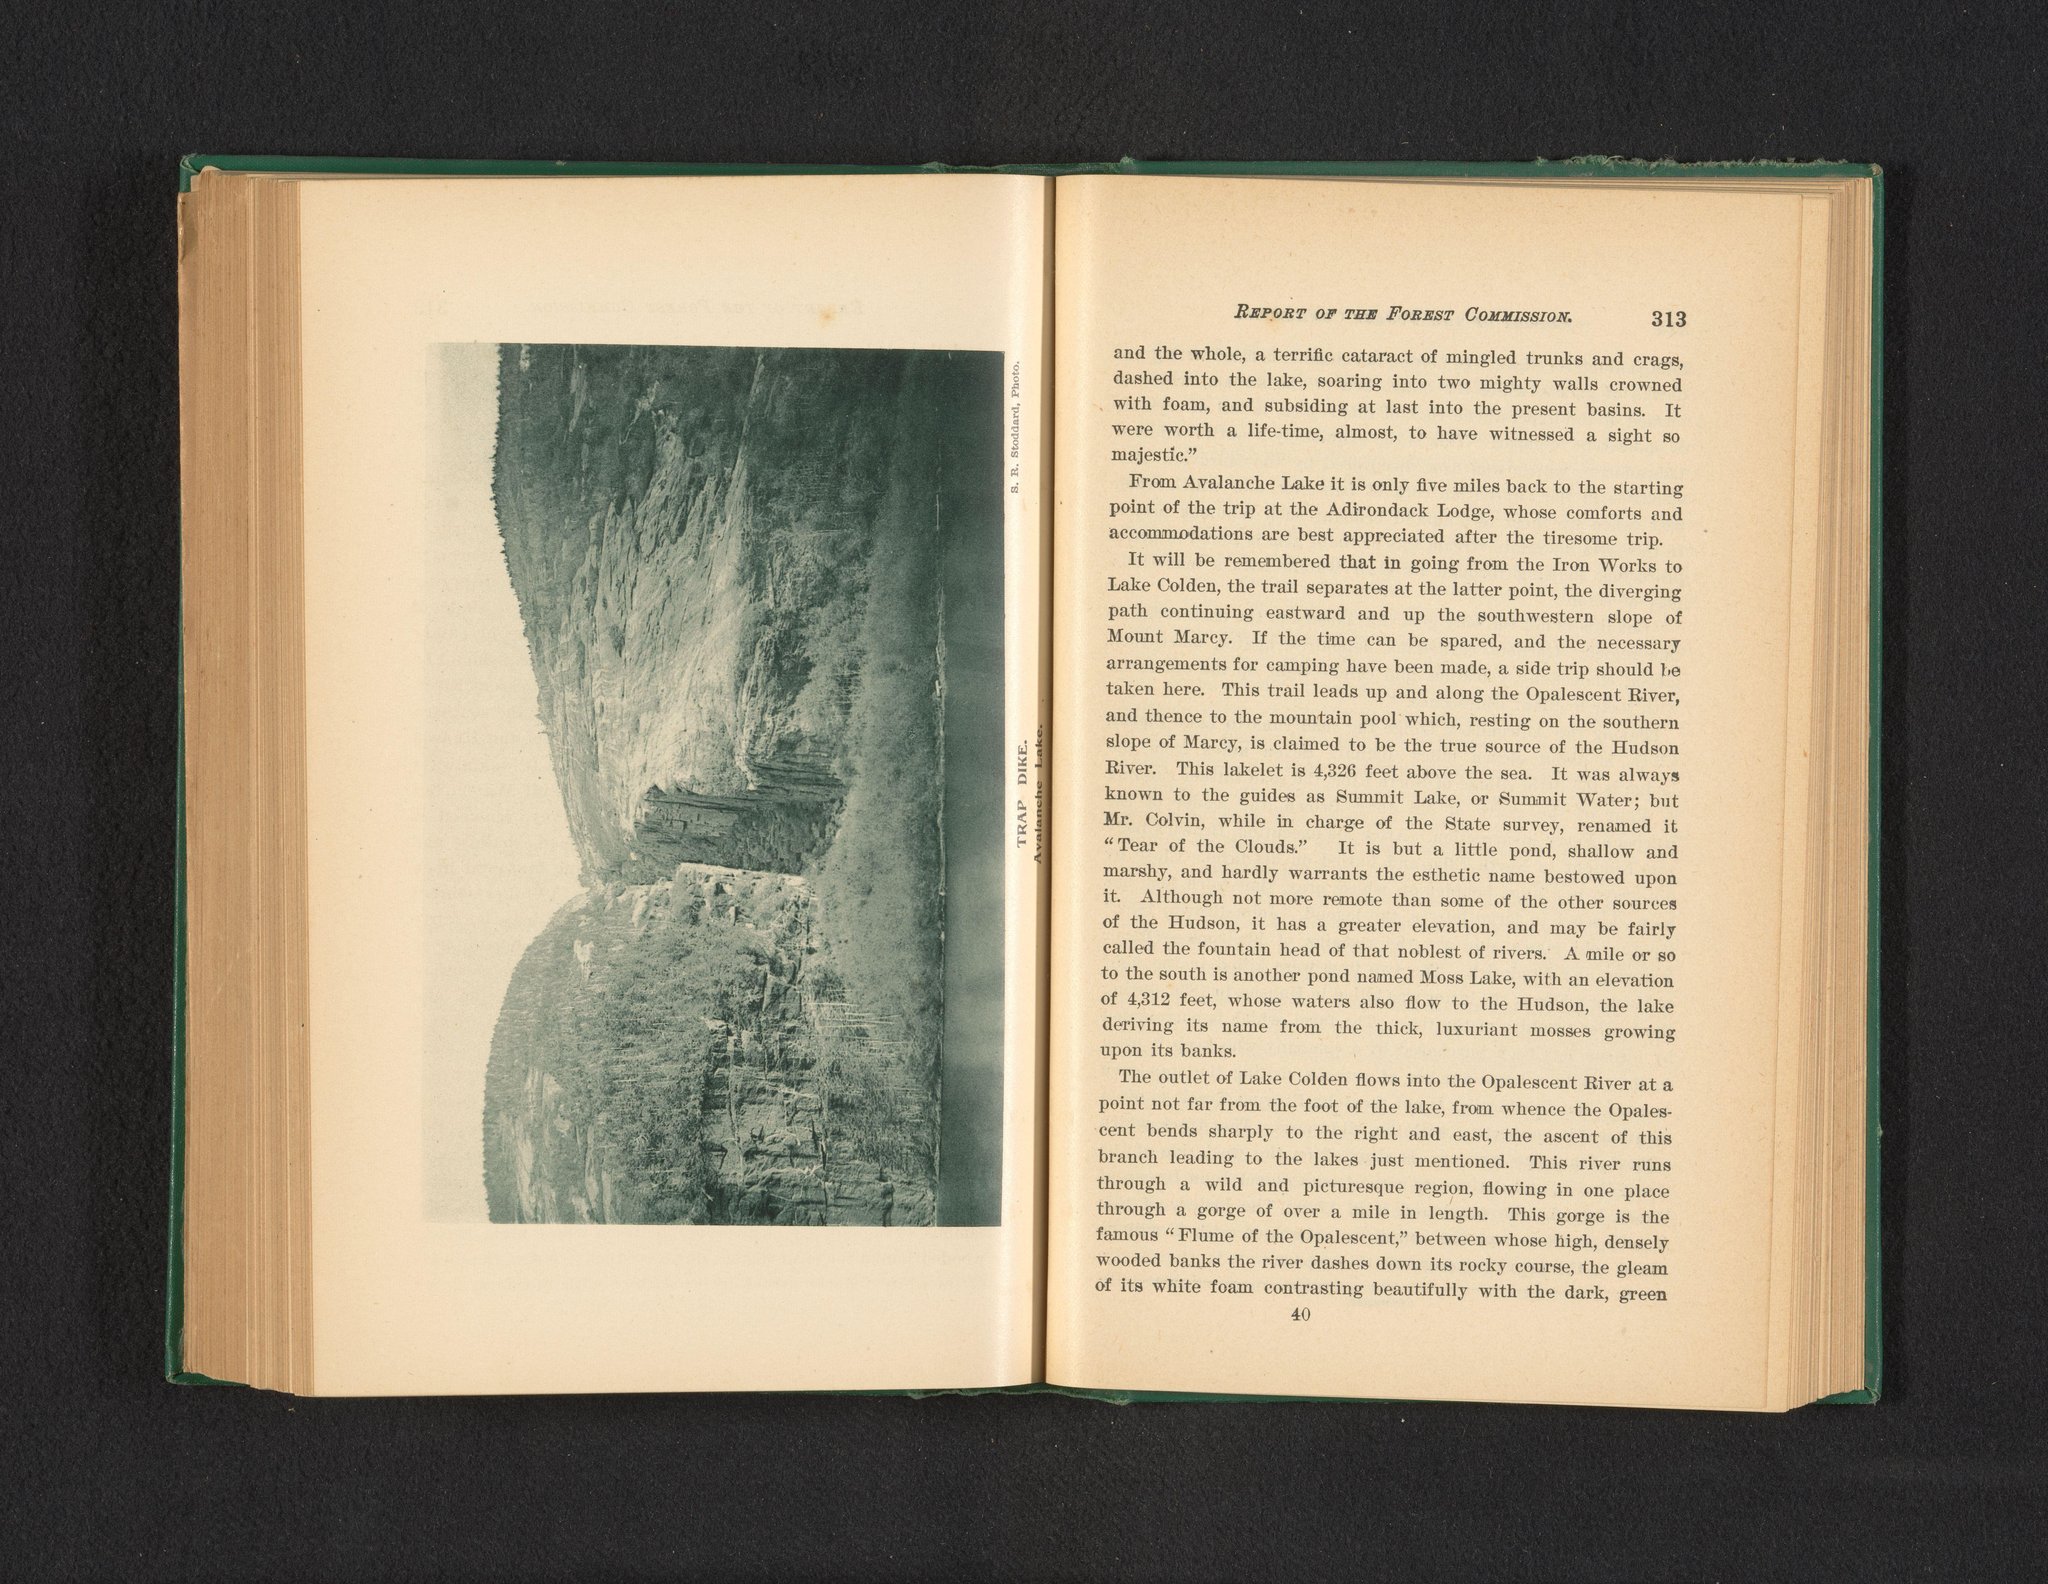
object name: page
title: Trap Dike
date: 1893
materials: paper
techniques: photograph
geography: new york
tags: river